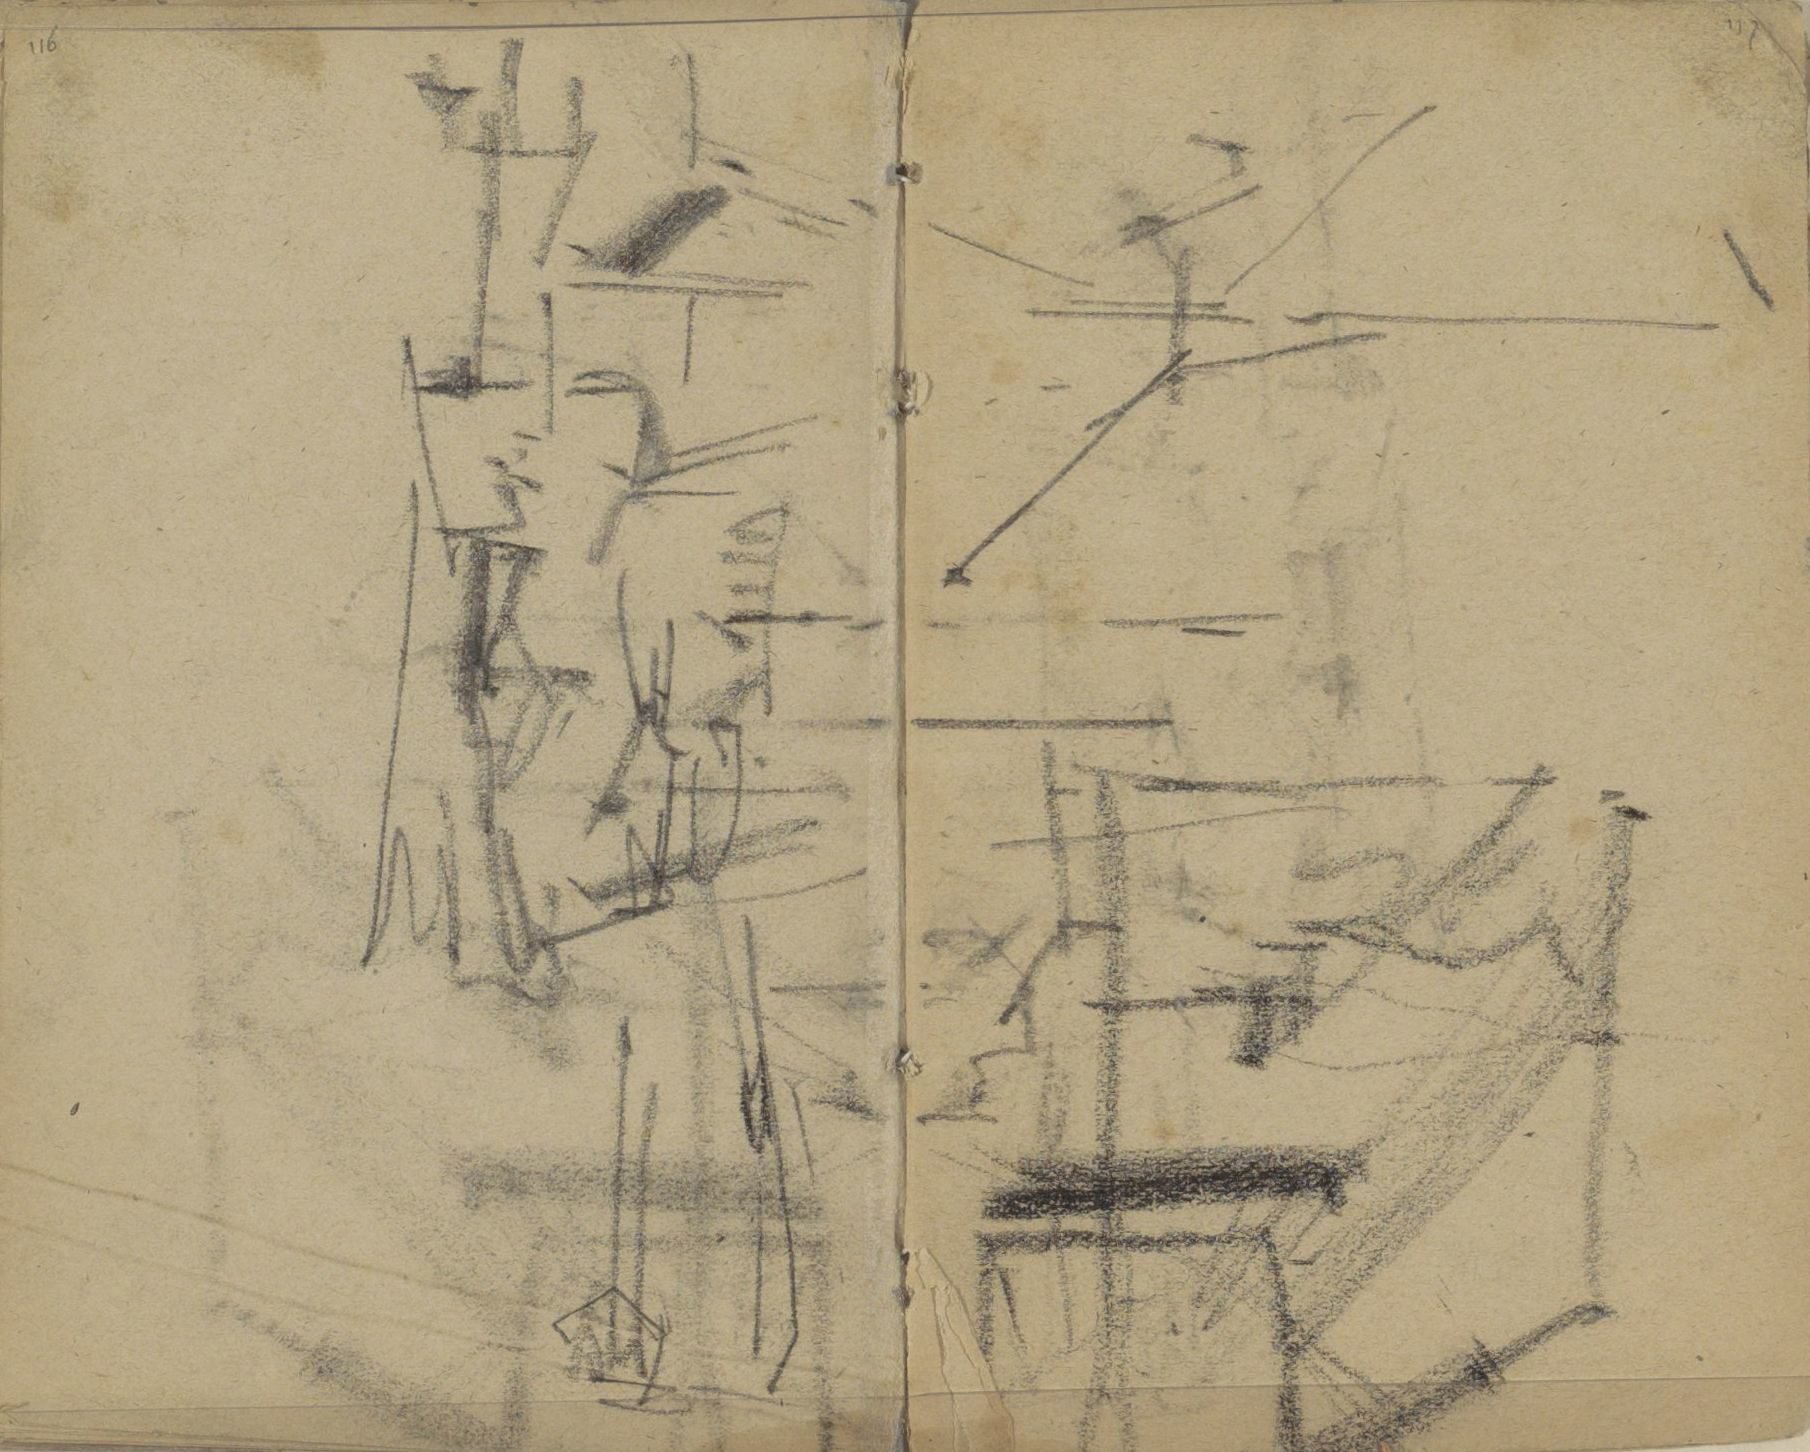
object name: sketchbook leaf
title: Studie, mogelijk een stadsgezicht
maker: george hendrik breitner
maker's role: draughtsman, painter, print maker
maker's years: 1857-1923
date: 1881-1883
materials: chalk, paper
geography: south holland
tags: city-view, and landscape with man-made constructions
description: Studie, mogelijk een stadsgezicht. Pagina 116 en pagina 117 uit een schetsboek met 70 bladen.